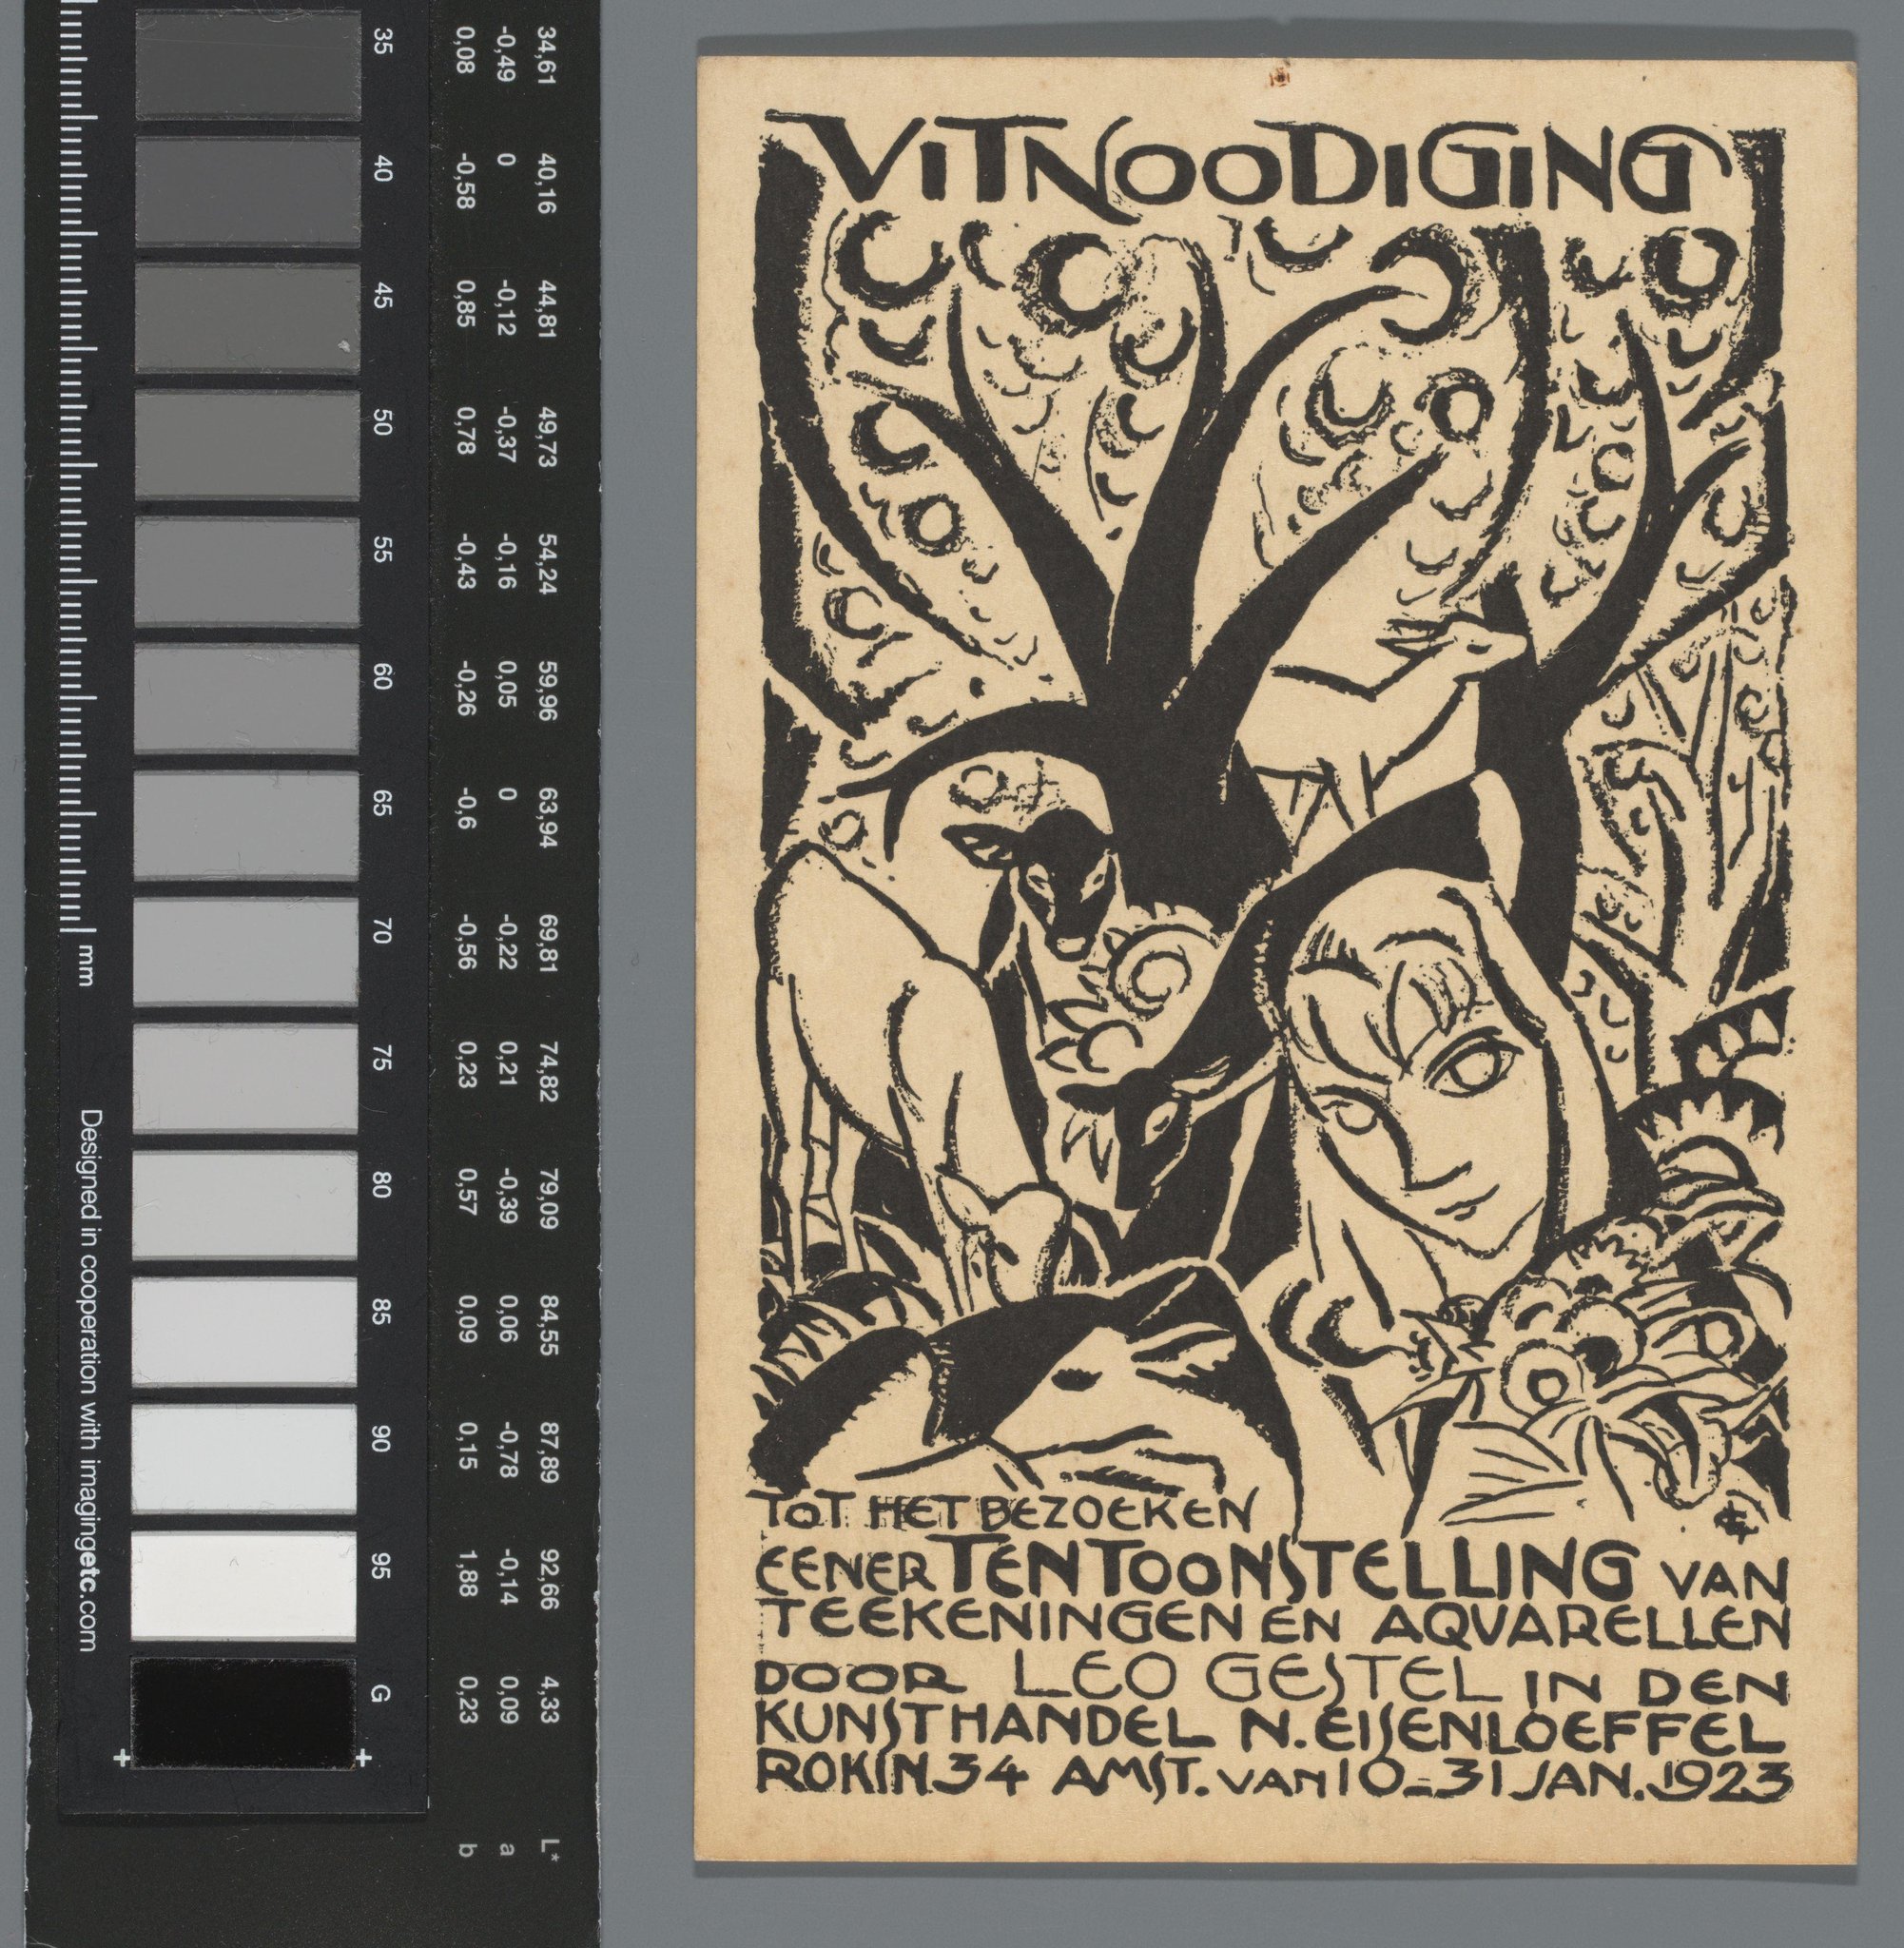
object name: print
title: Uitnodiging voor een tentoonstelling van tekeningen en aquarellen van Leo Gestel in Kunsthandel N. Eisenloeffel te Amsterdam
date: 1923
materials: cardboard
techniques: lithograph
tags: nico eisenloeffel, print maker, draughtsman, leo gestel, adult woman, animals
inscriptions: date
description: Uitnodiging maakt deel uit van een album.